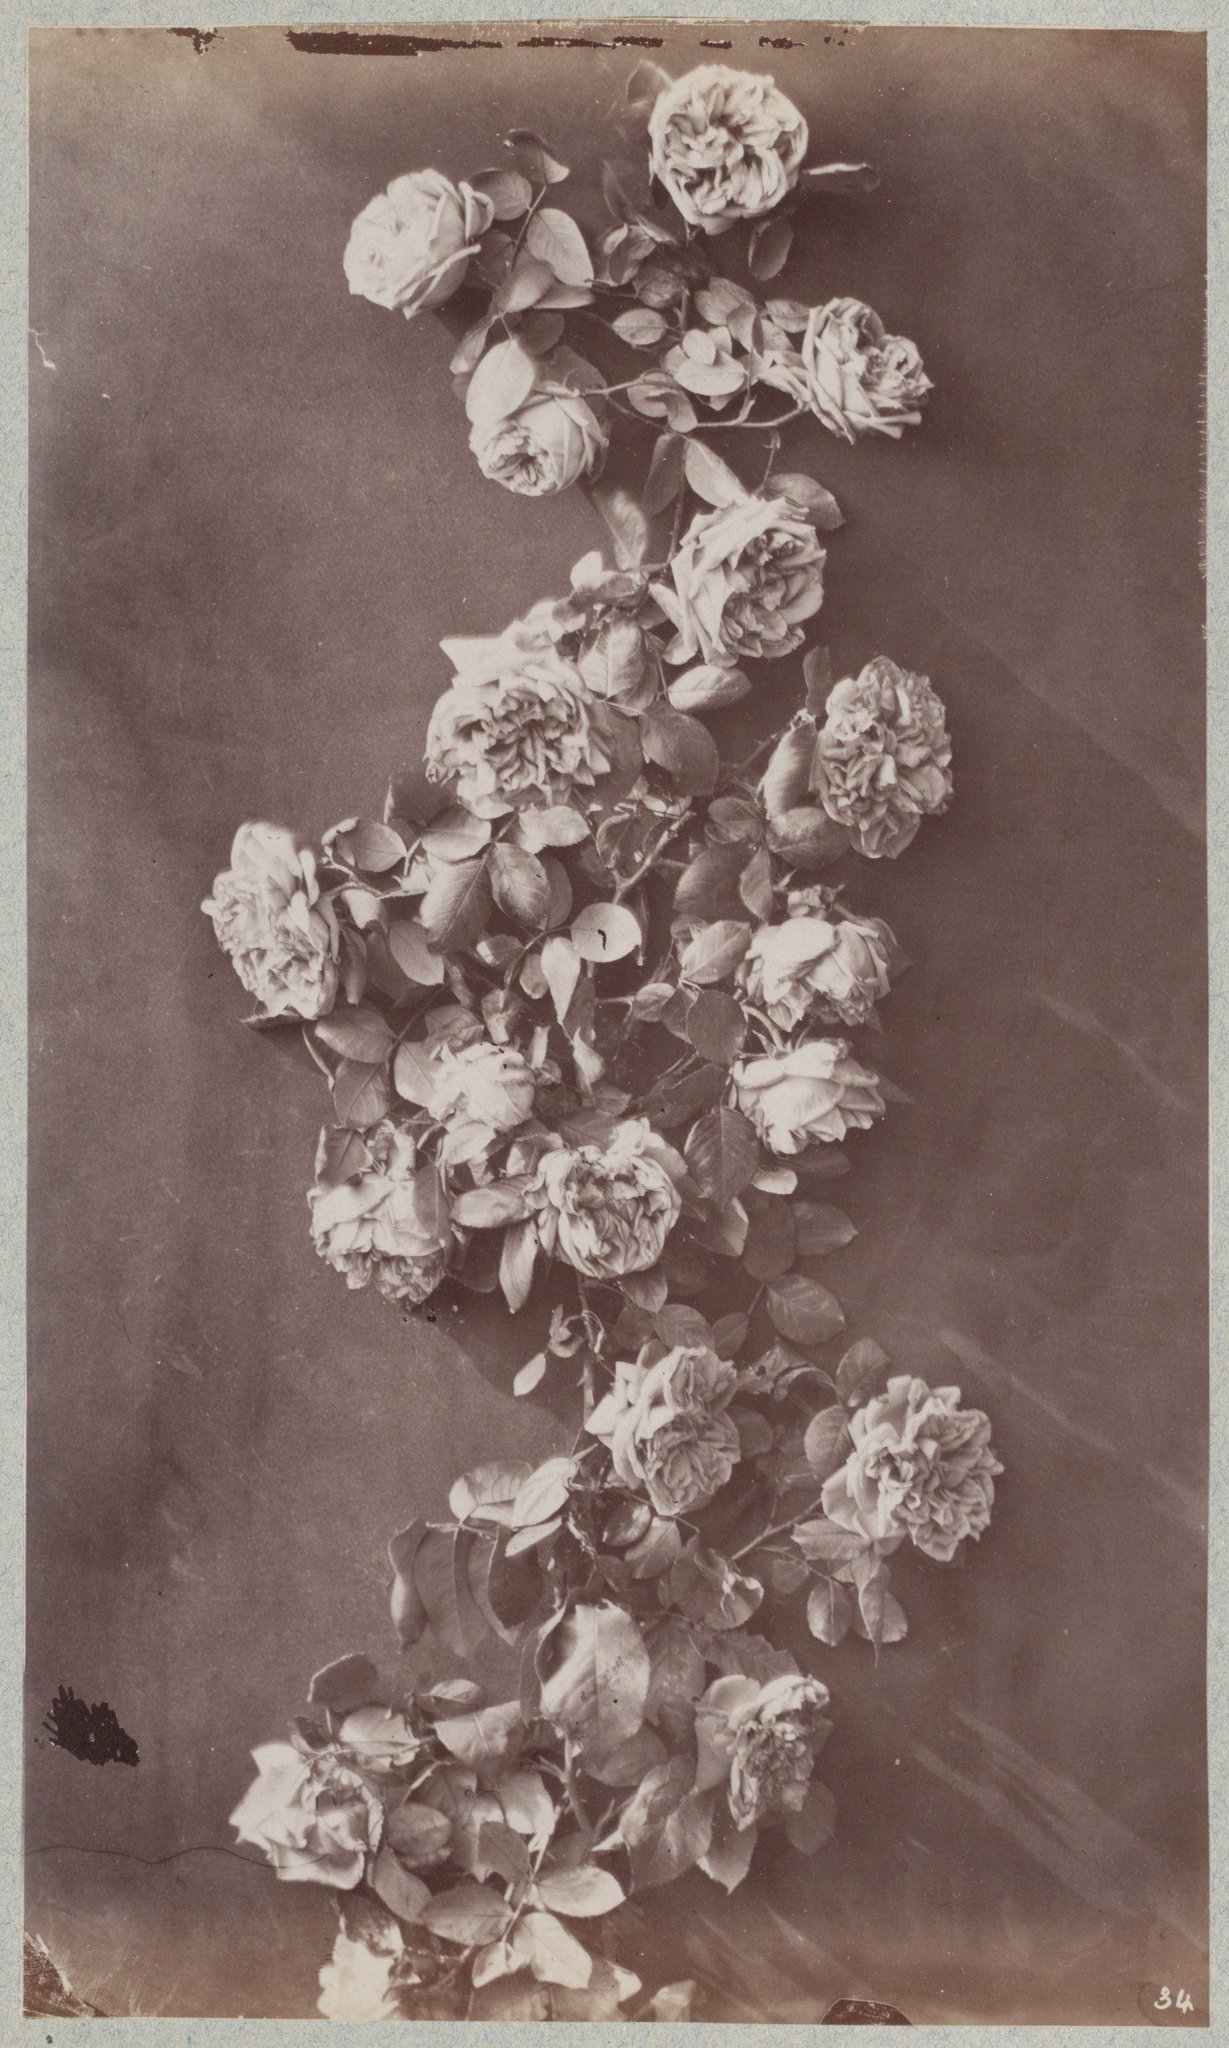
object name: photograph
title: Bloemstudie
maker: a. calavas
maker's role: publisher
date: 1875-1895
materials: cardboard, photographic support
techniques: albumen print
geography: paris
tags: flowers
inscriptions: number: ‘34’, collector's mark: Lugt 3937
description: Onderdeel van Verzamelband met foto's van bloemstudies.